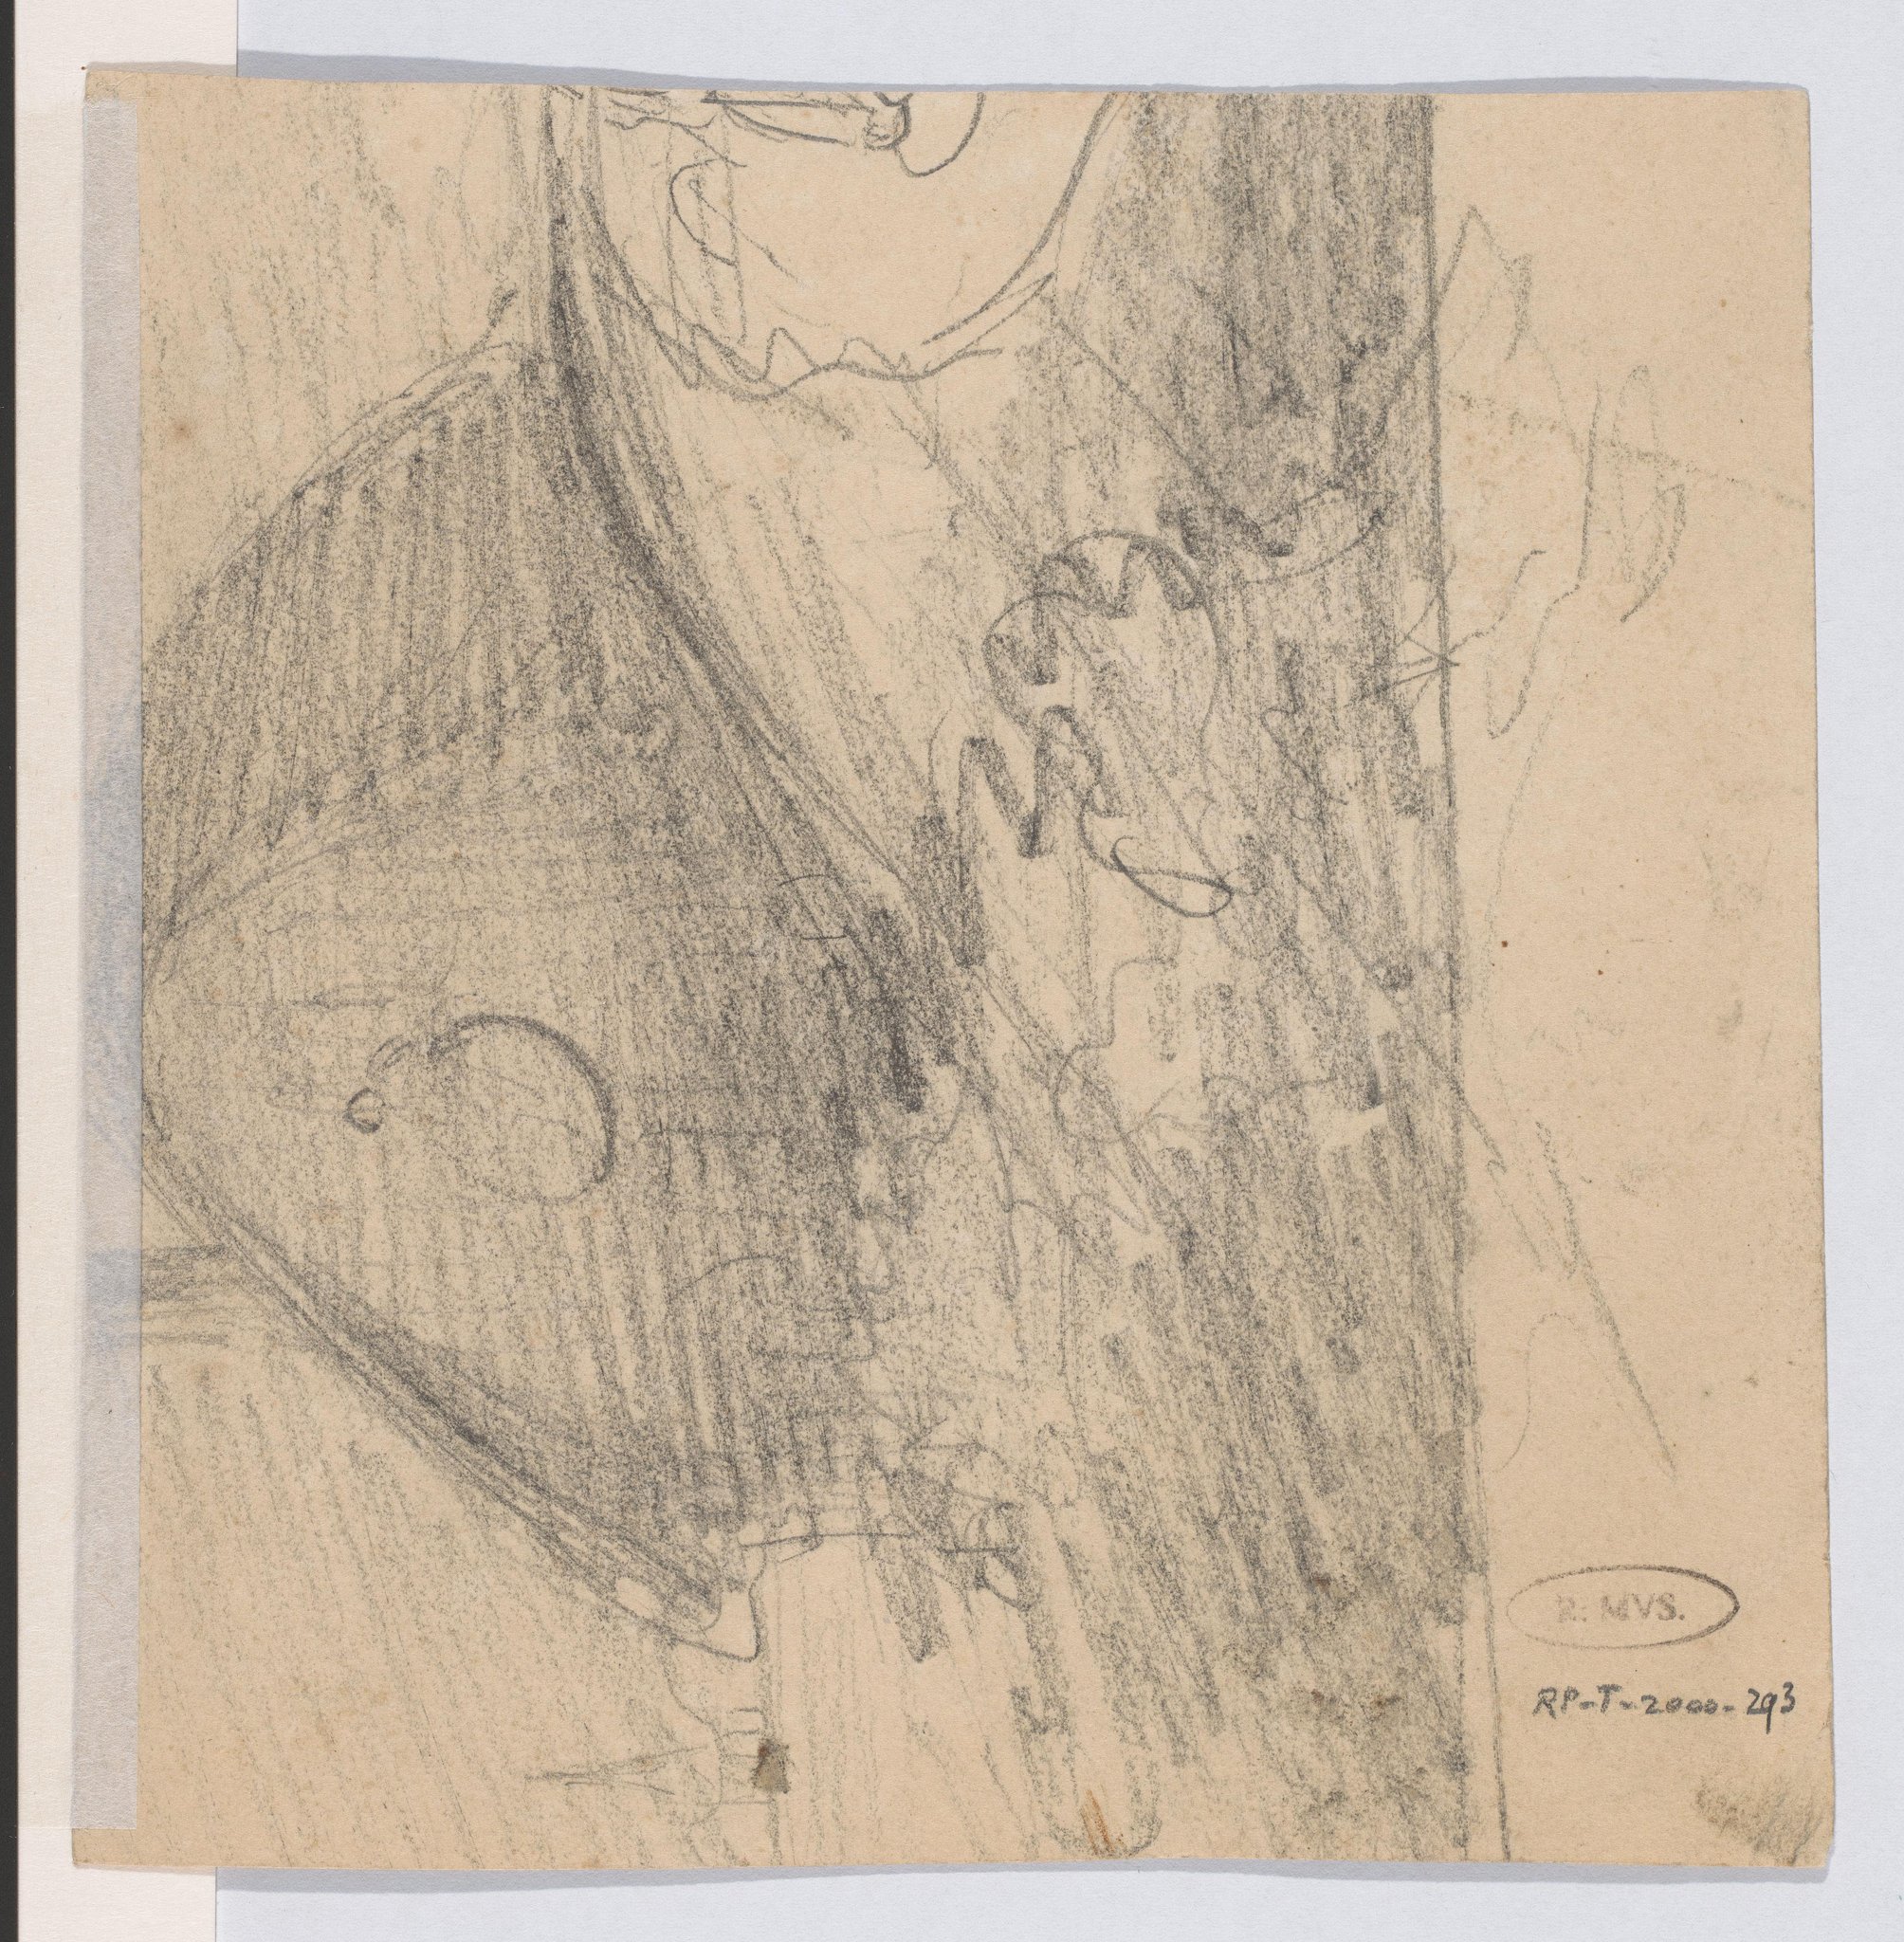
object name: drawing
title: Huis (deel van een grotere voorstelling)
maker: johannes tavenraat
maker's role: draughtsman, painter, print maker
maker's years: 1809-1881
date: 1840-1880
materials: chalk, paper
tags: rural housing, e.g. country-house, villa, cottage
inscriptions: collector's mark: Lugt 2228